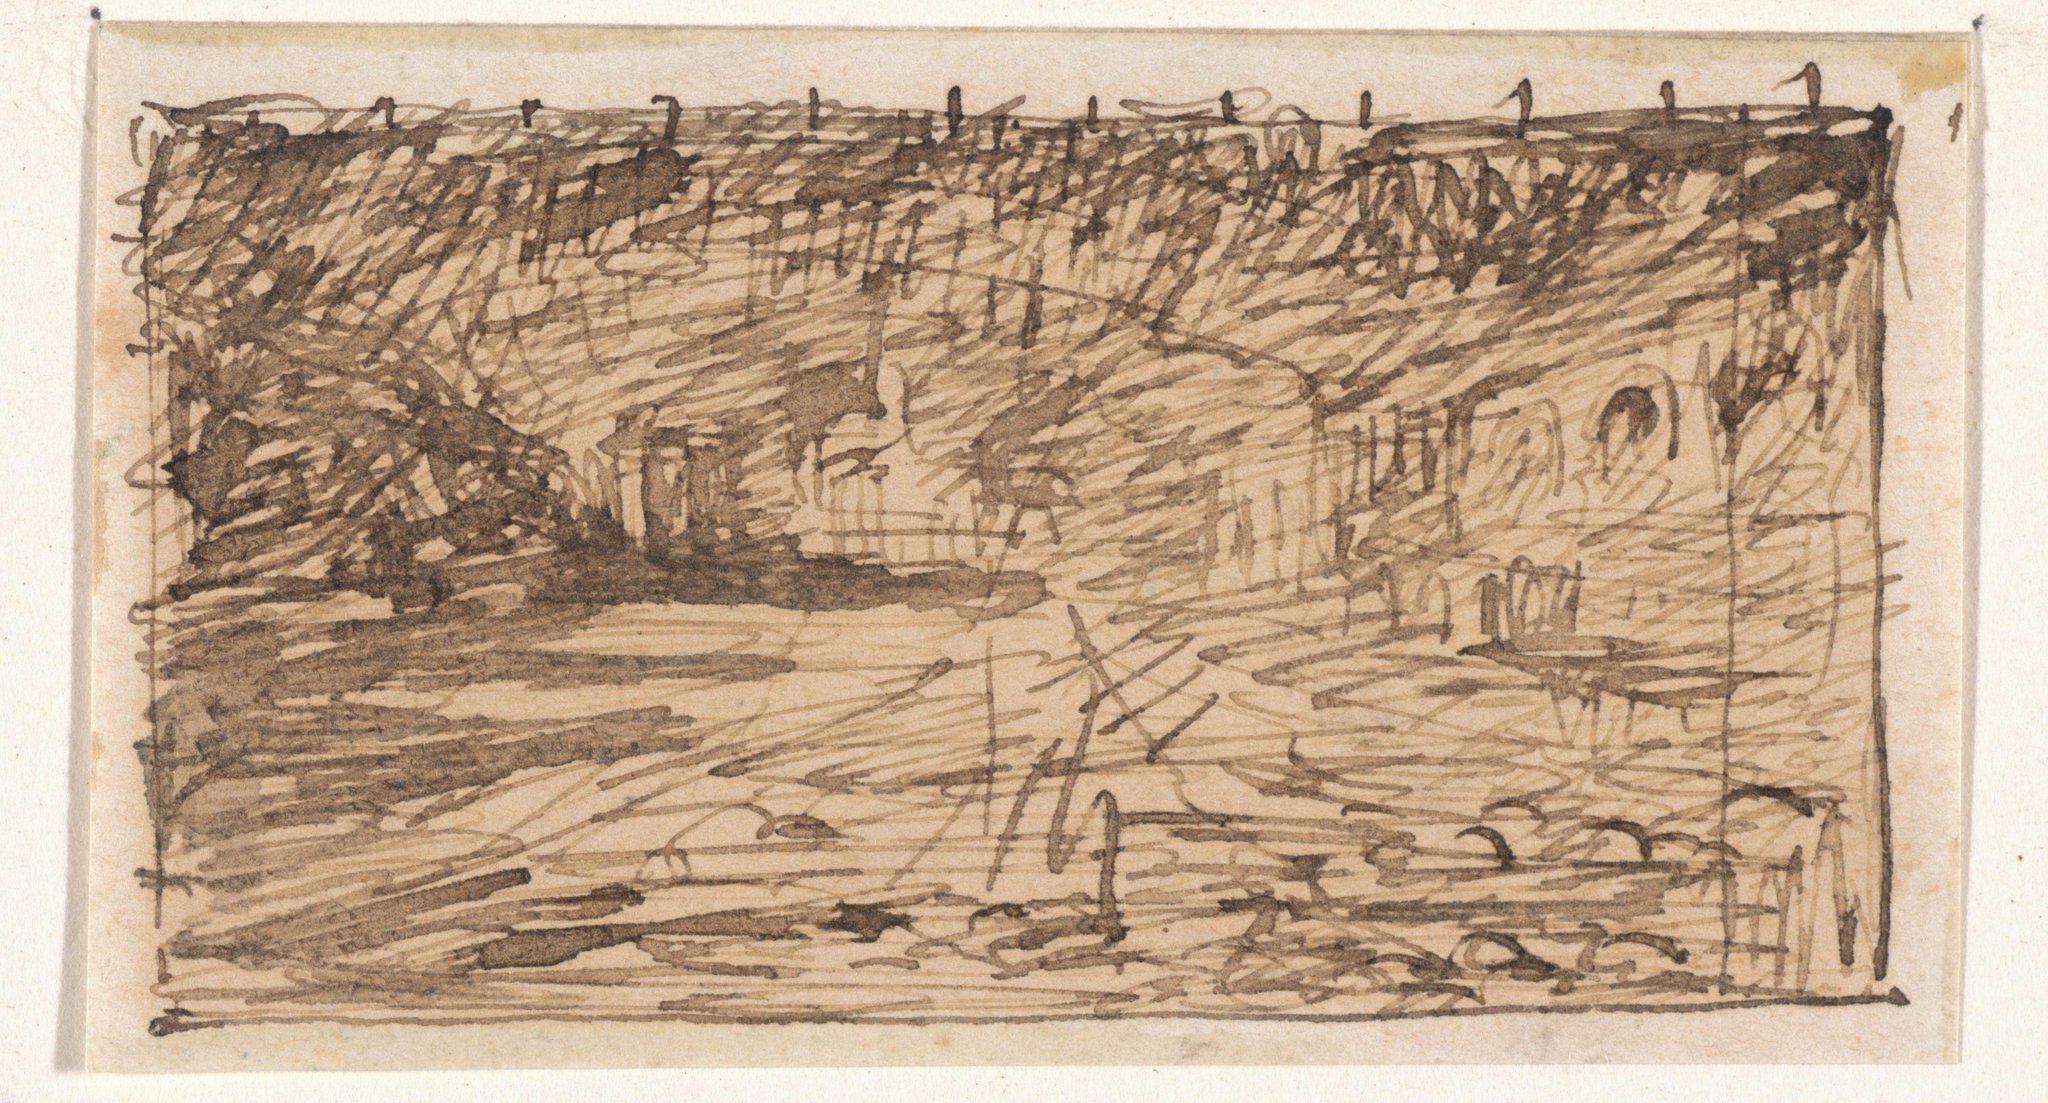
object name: drawing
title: Klassieke architectuur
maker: thomas cool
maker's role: draughtsman, painter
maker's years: 1851-1904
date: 1861-1904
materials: ink, paper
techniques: pen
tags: landscape with ruins, rome